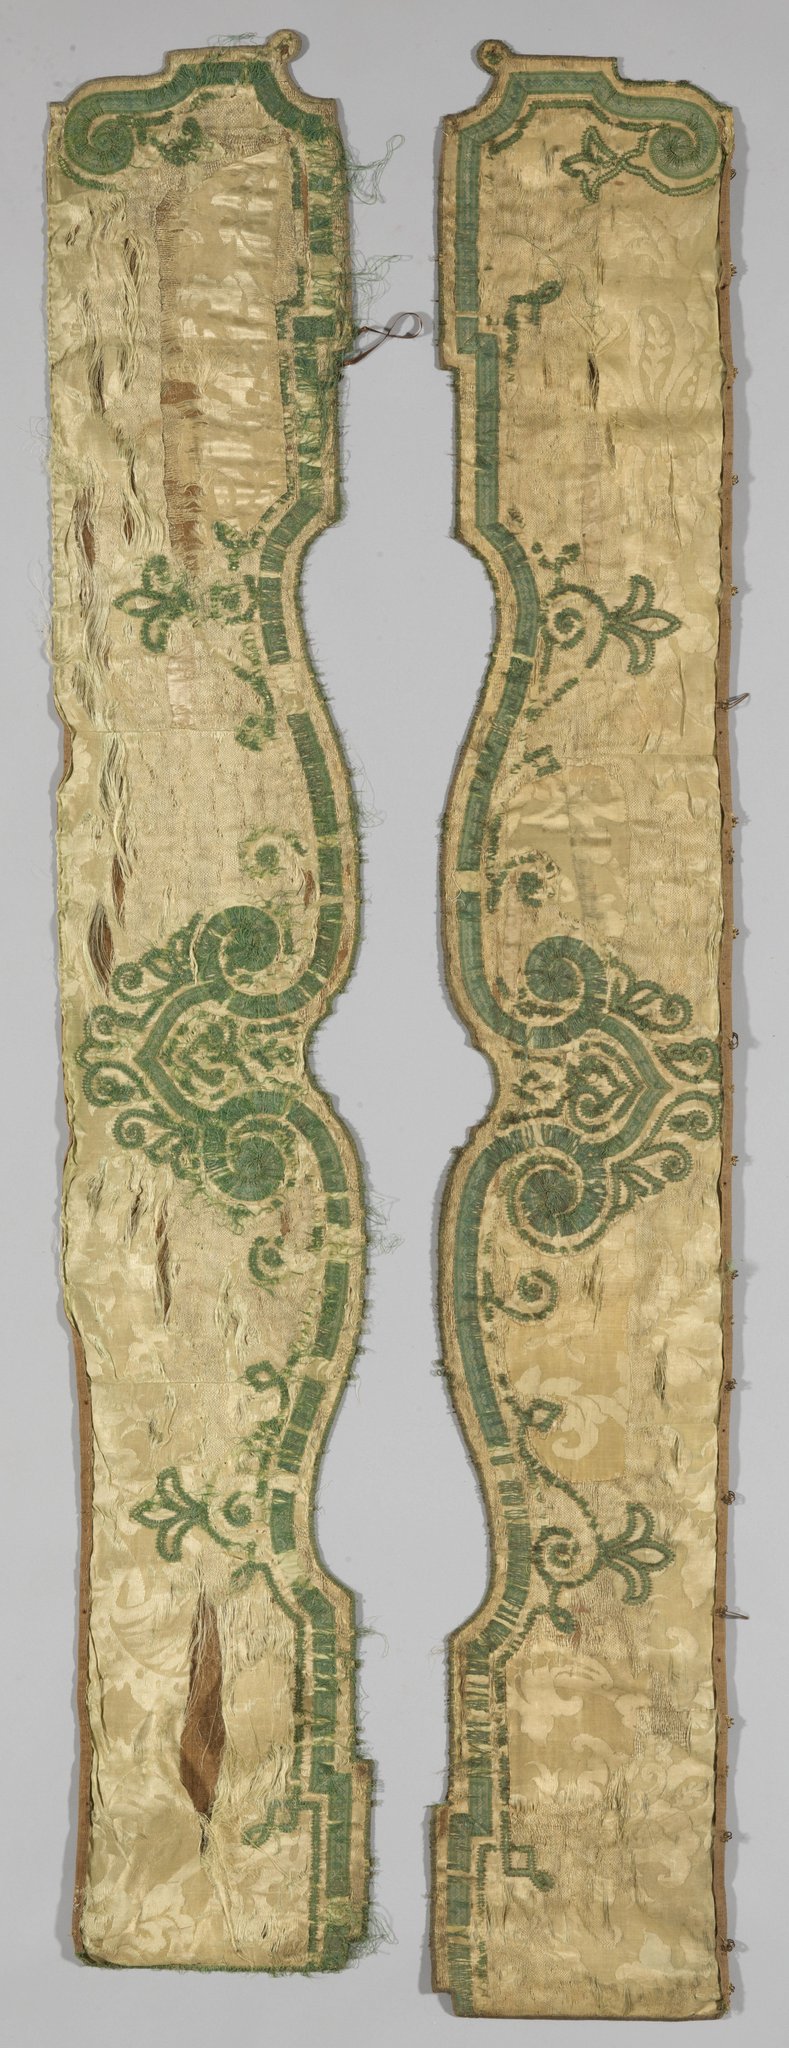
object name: bed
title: Four-poster bed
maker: Anonymous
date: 1715-1720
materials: silk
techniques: damask, embroidered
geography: netherlands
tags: ornament derived from plant forms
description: Twee gelobte vallen van wit zijdedamast met groen passement en linnen of jute voering. Eén met haken.